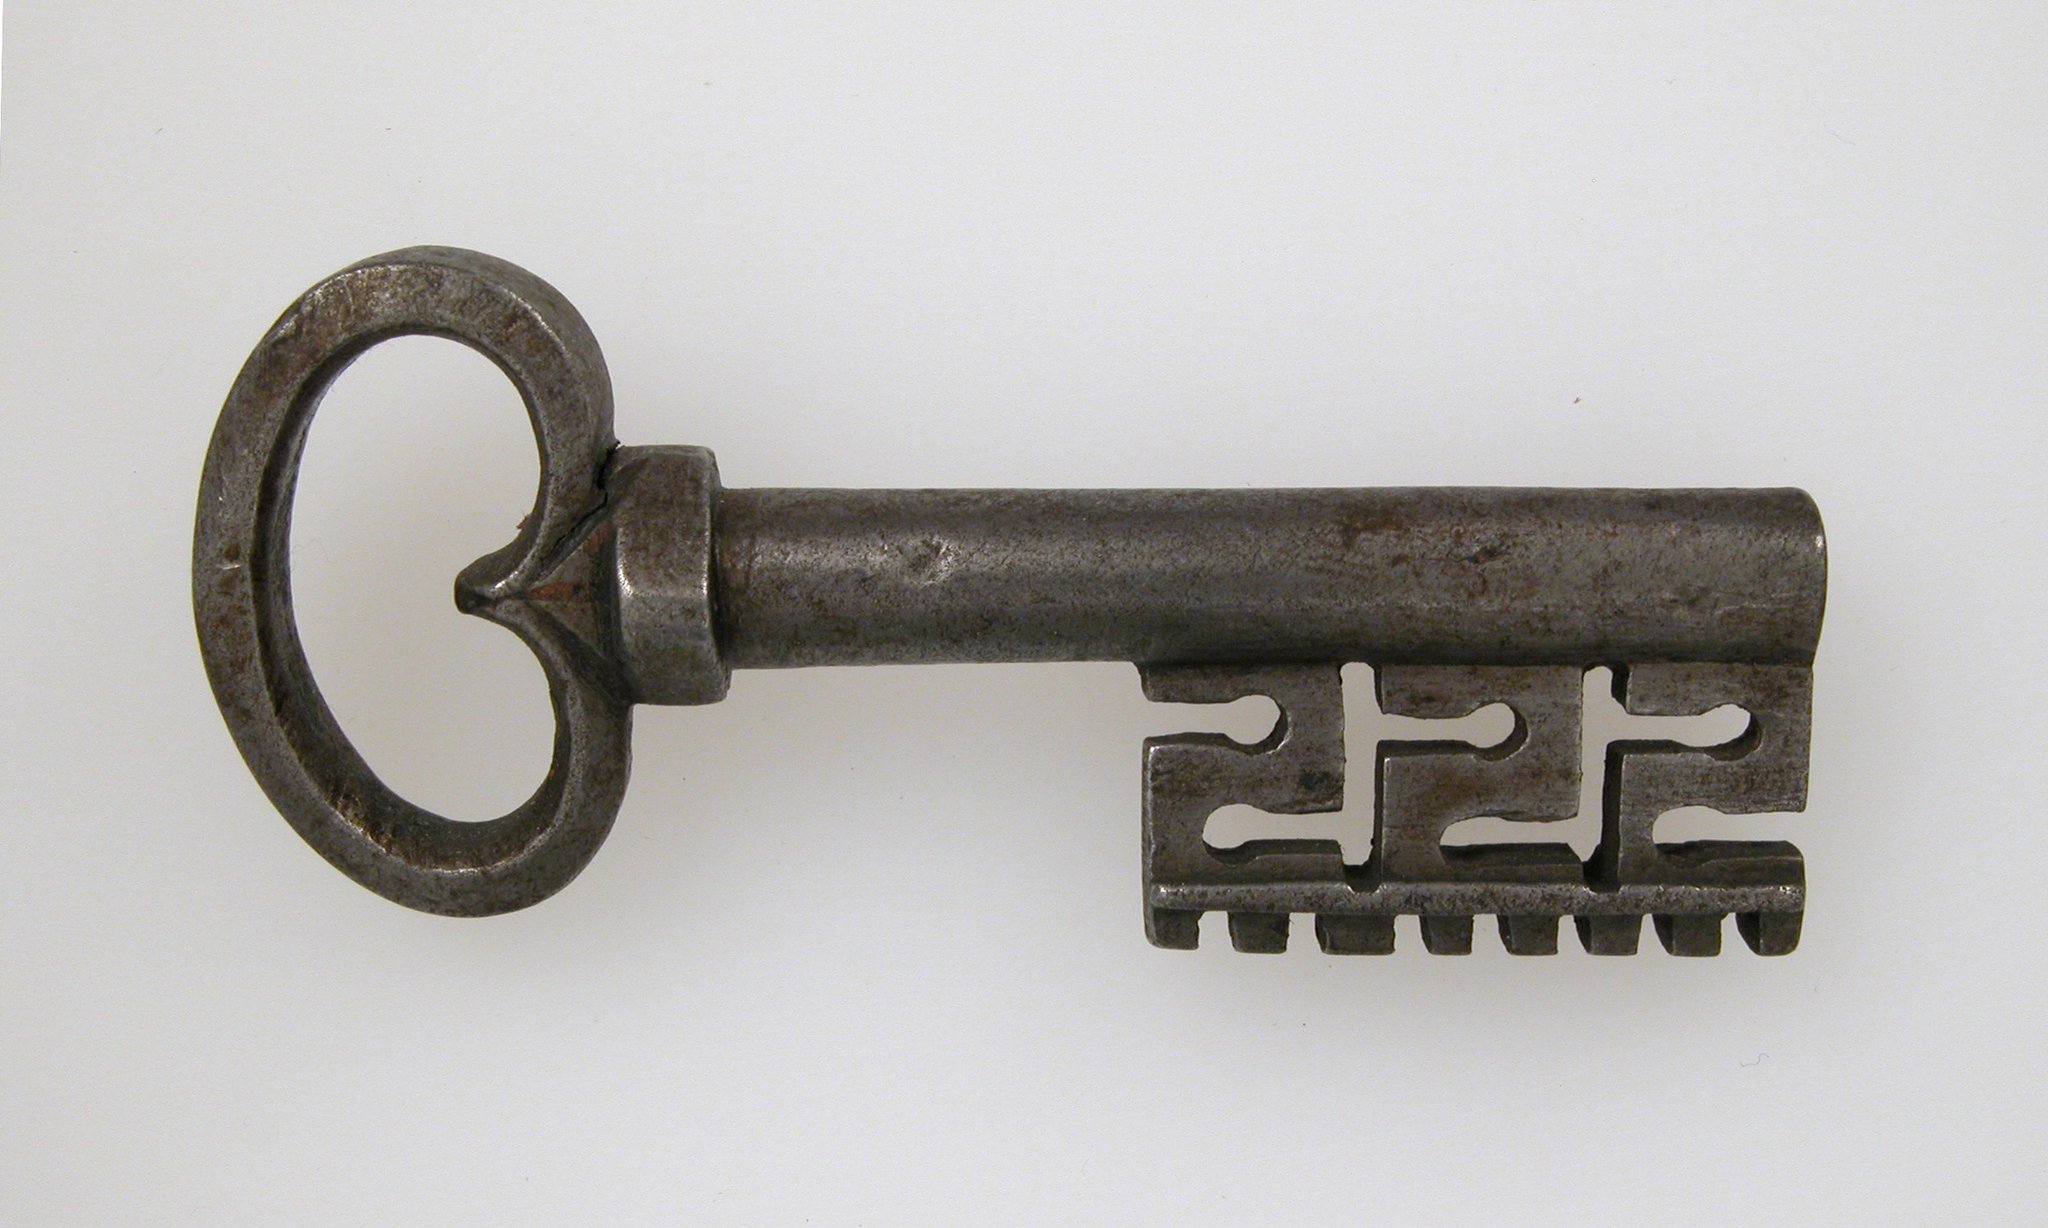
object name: key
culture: german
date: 1401-1500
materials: iron